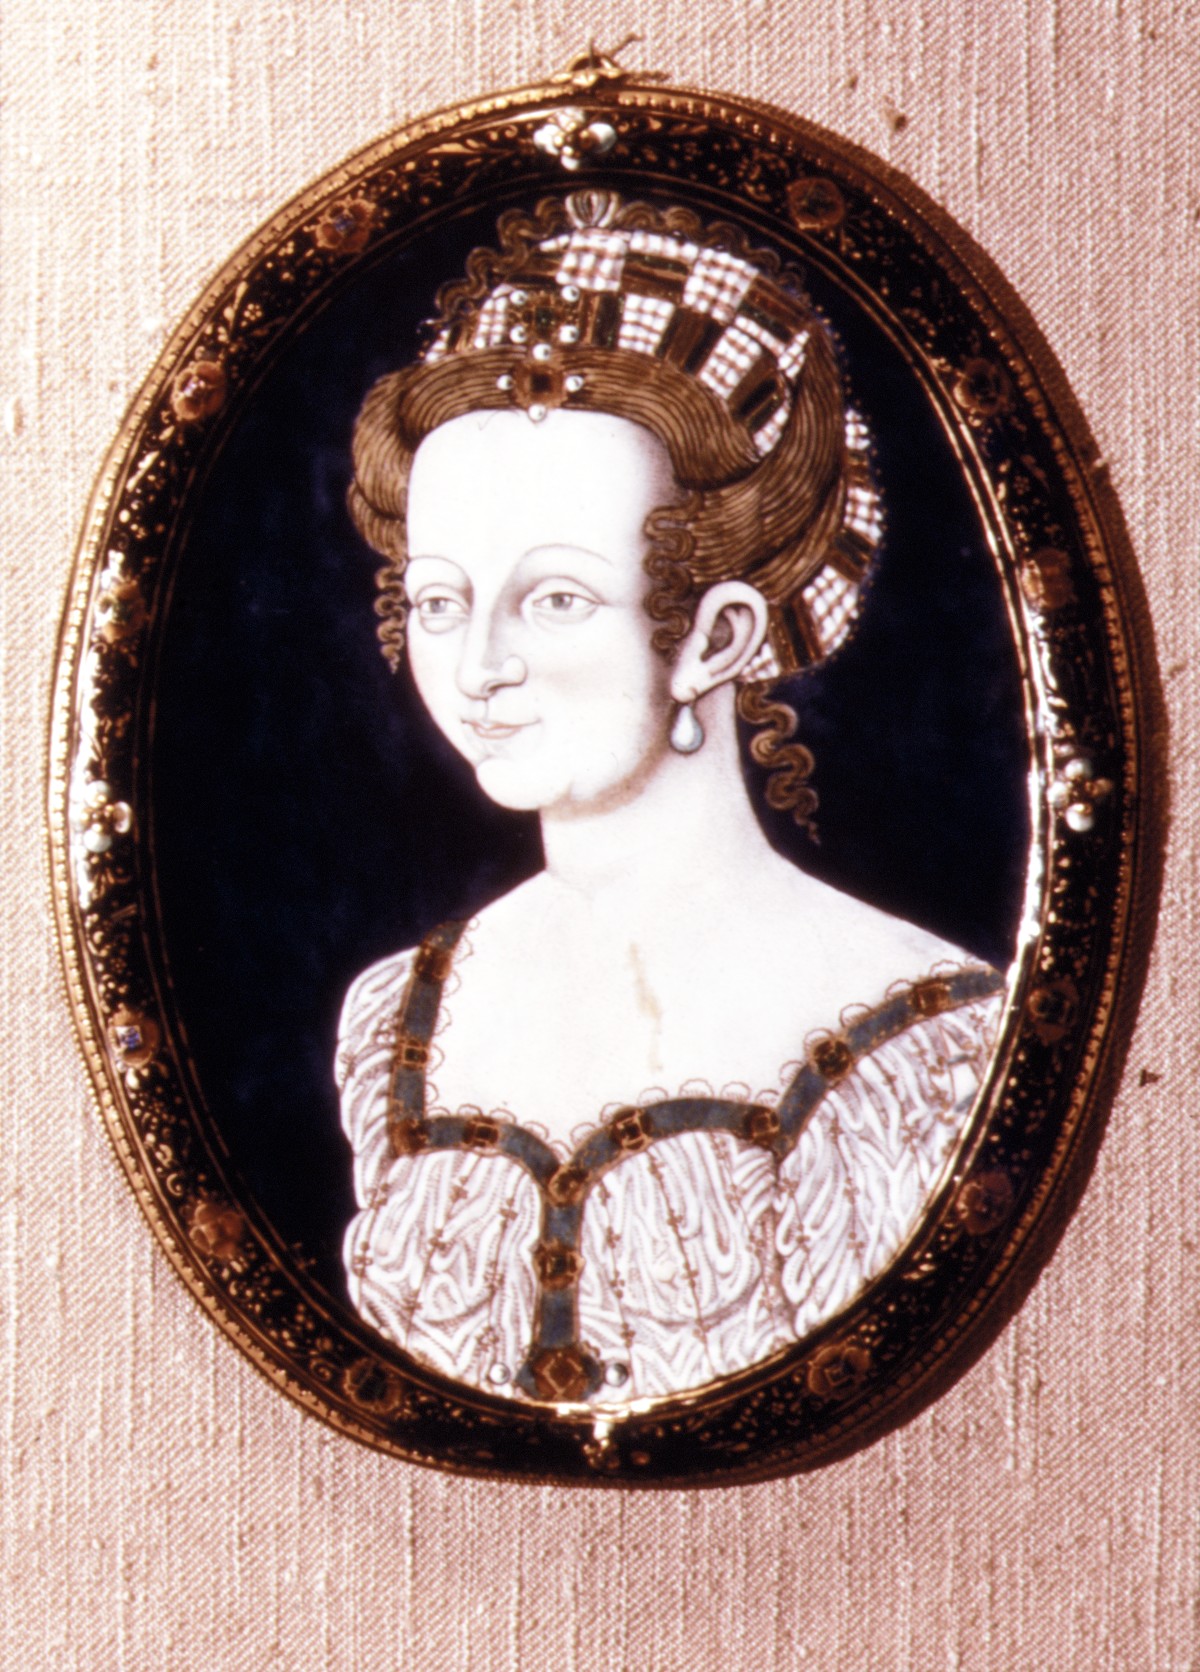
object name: plaque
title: Portrait of a lady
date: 1801-1900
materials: copper, enamel, gilt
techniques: painting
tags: portraits,women